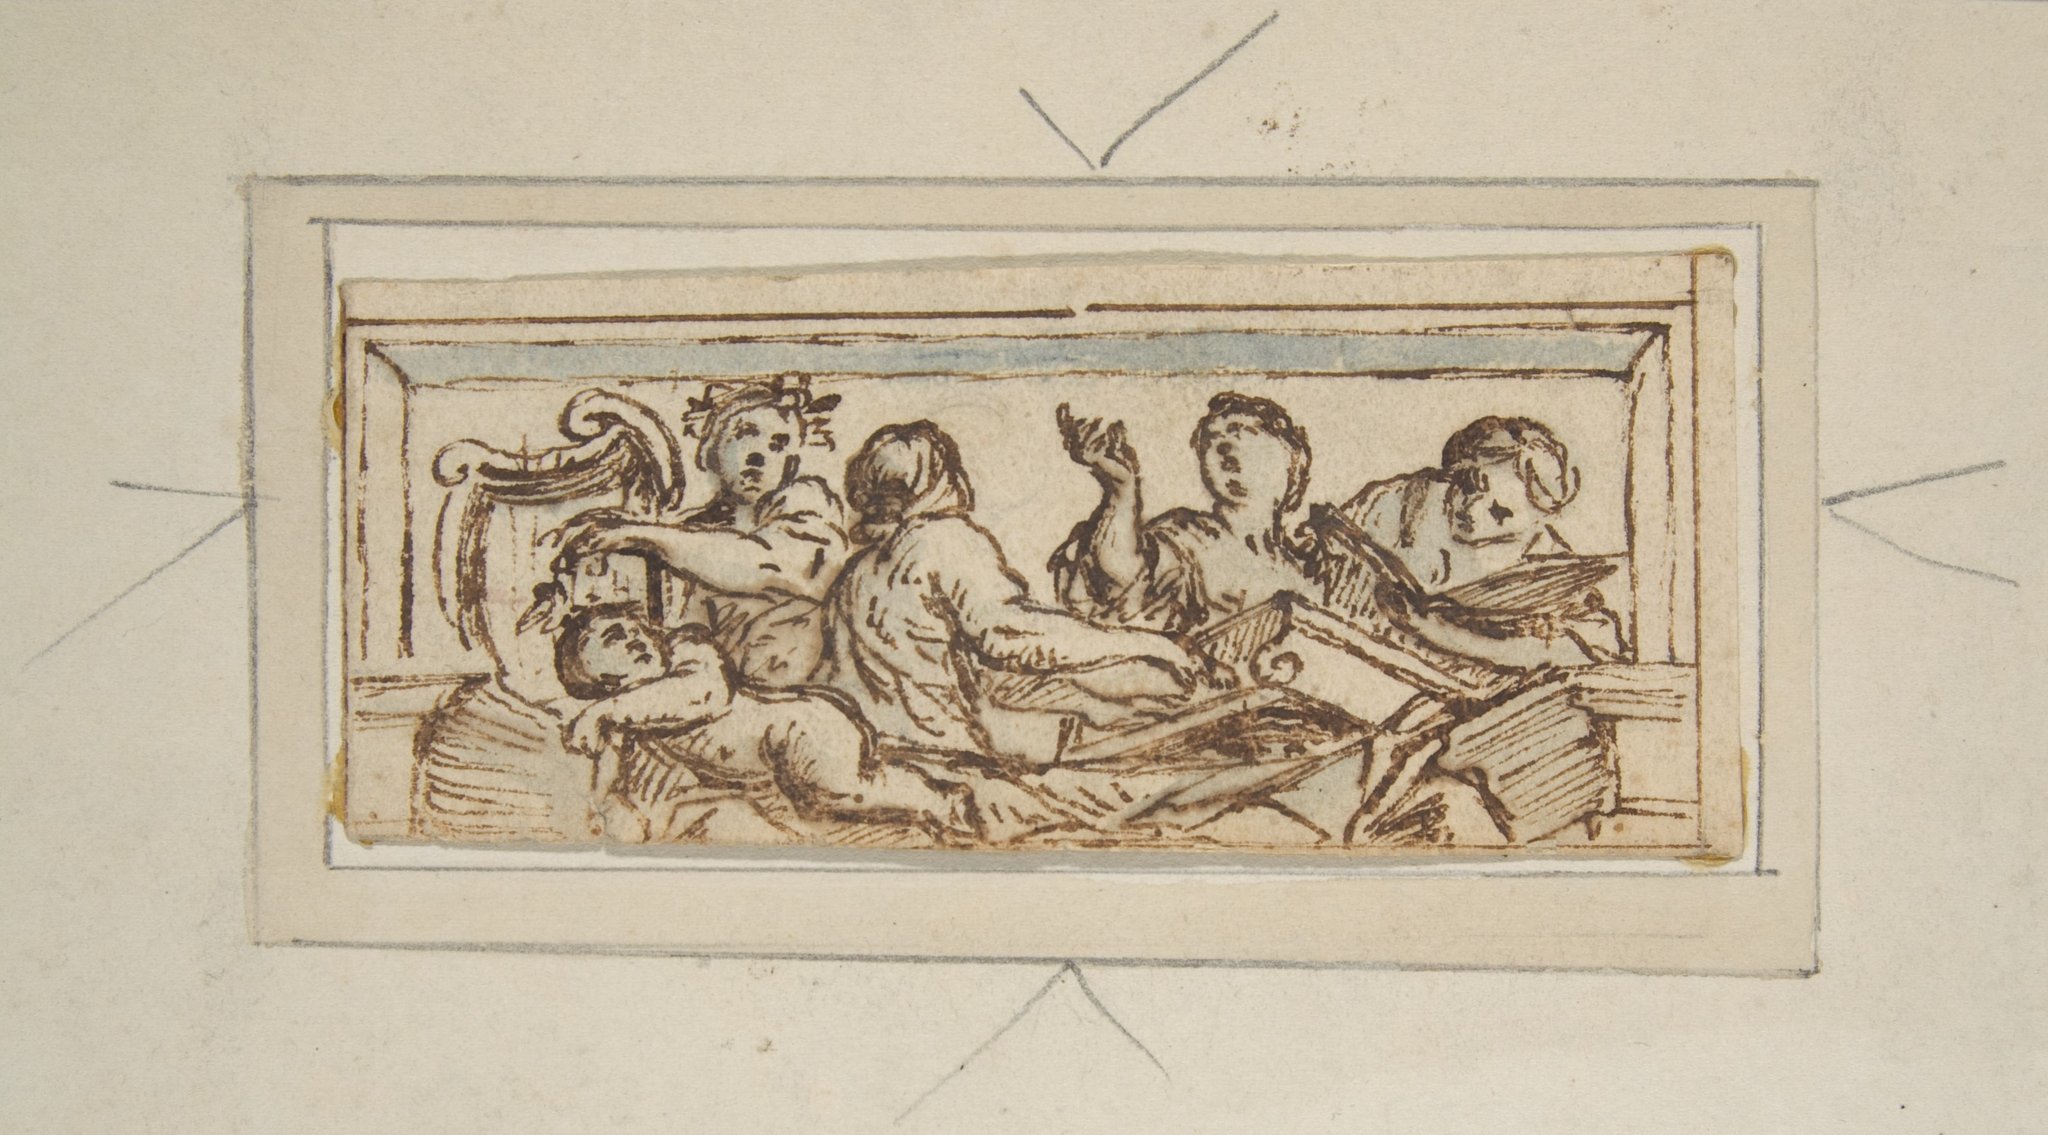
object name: drawing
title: Five Music-Making Figures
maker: giovanni francesco romanelli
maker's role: artist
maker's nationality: italian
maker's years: 1610-1662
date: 1610-1662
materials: ink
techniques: brush, pen, wash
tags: men,women,music,harps,musicians